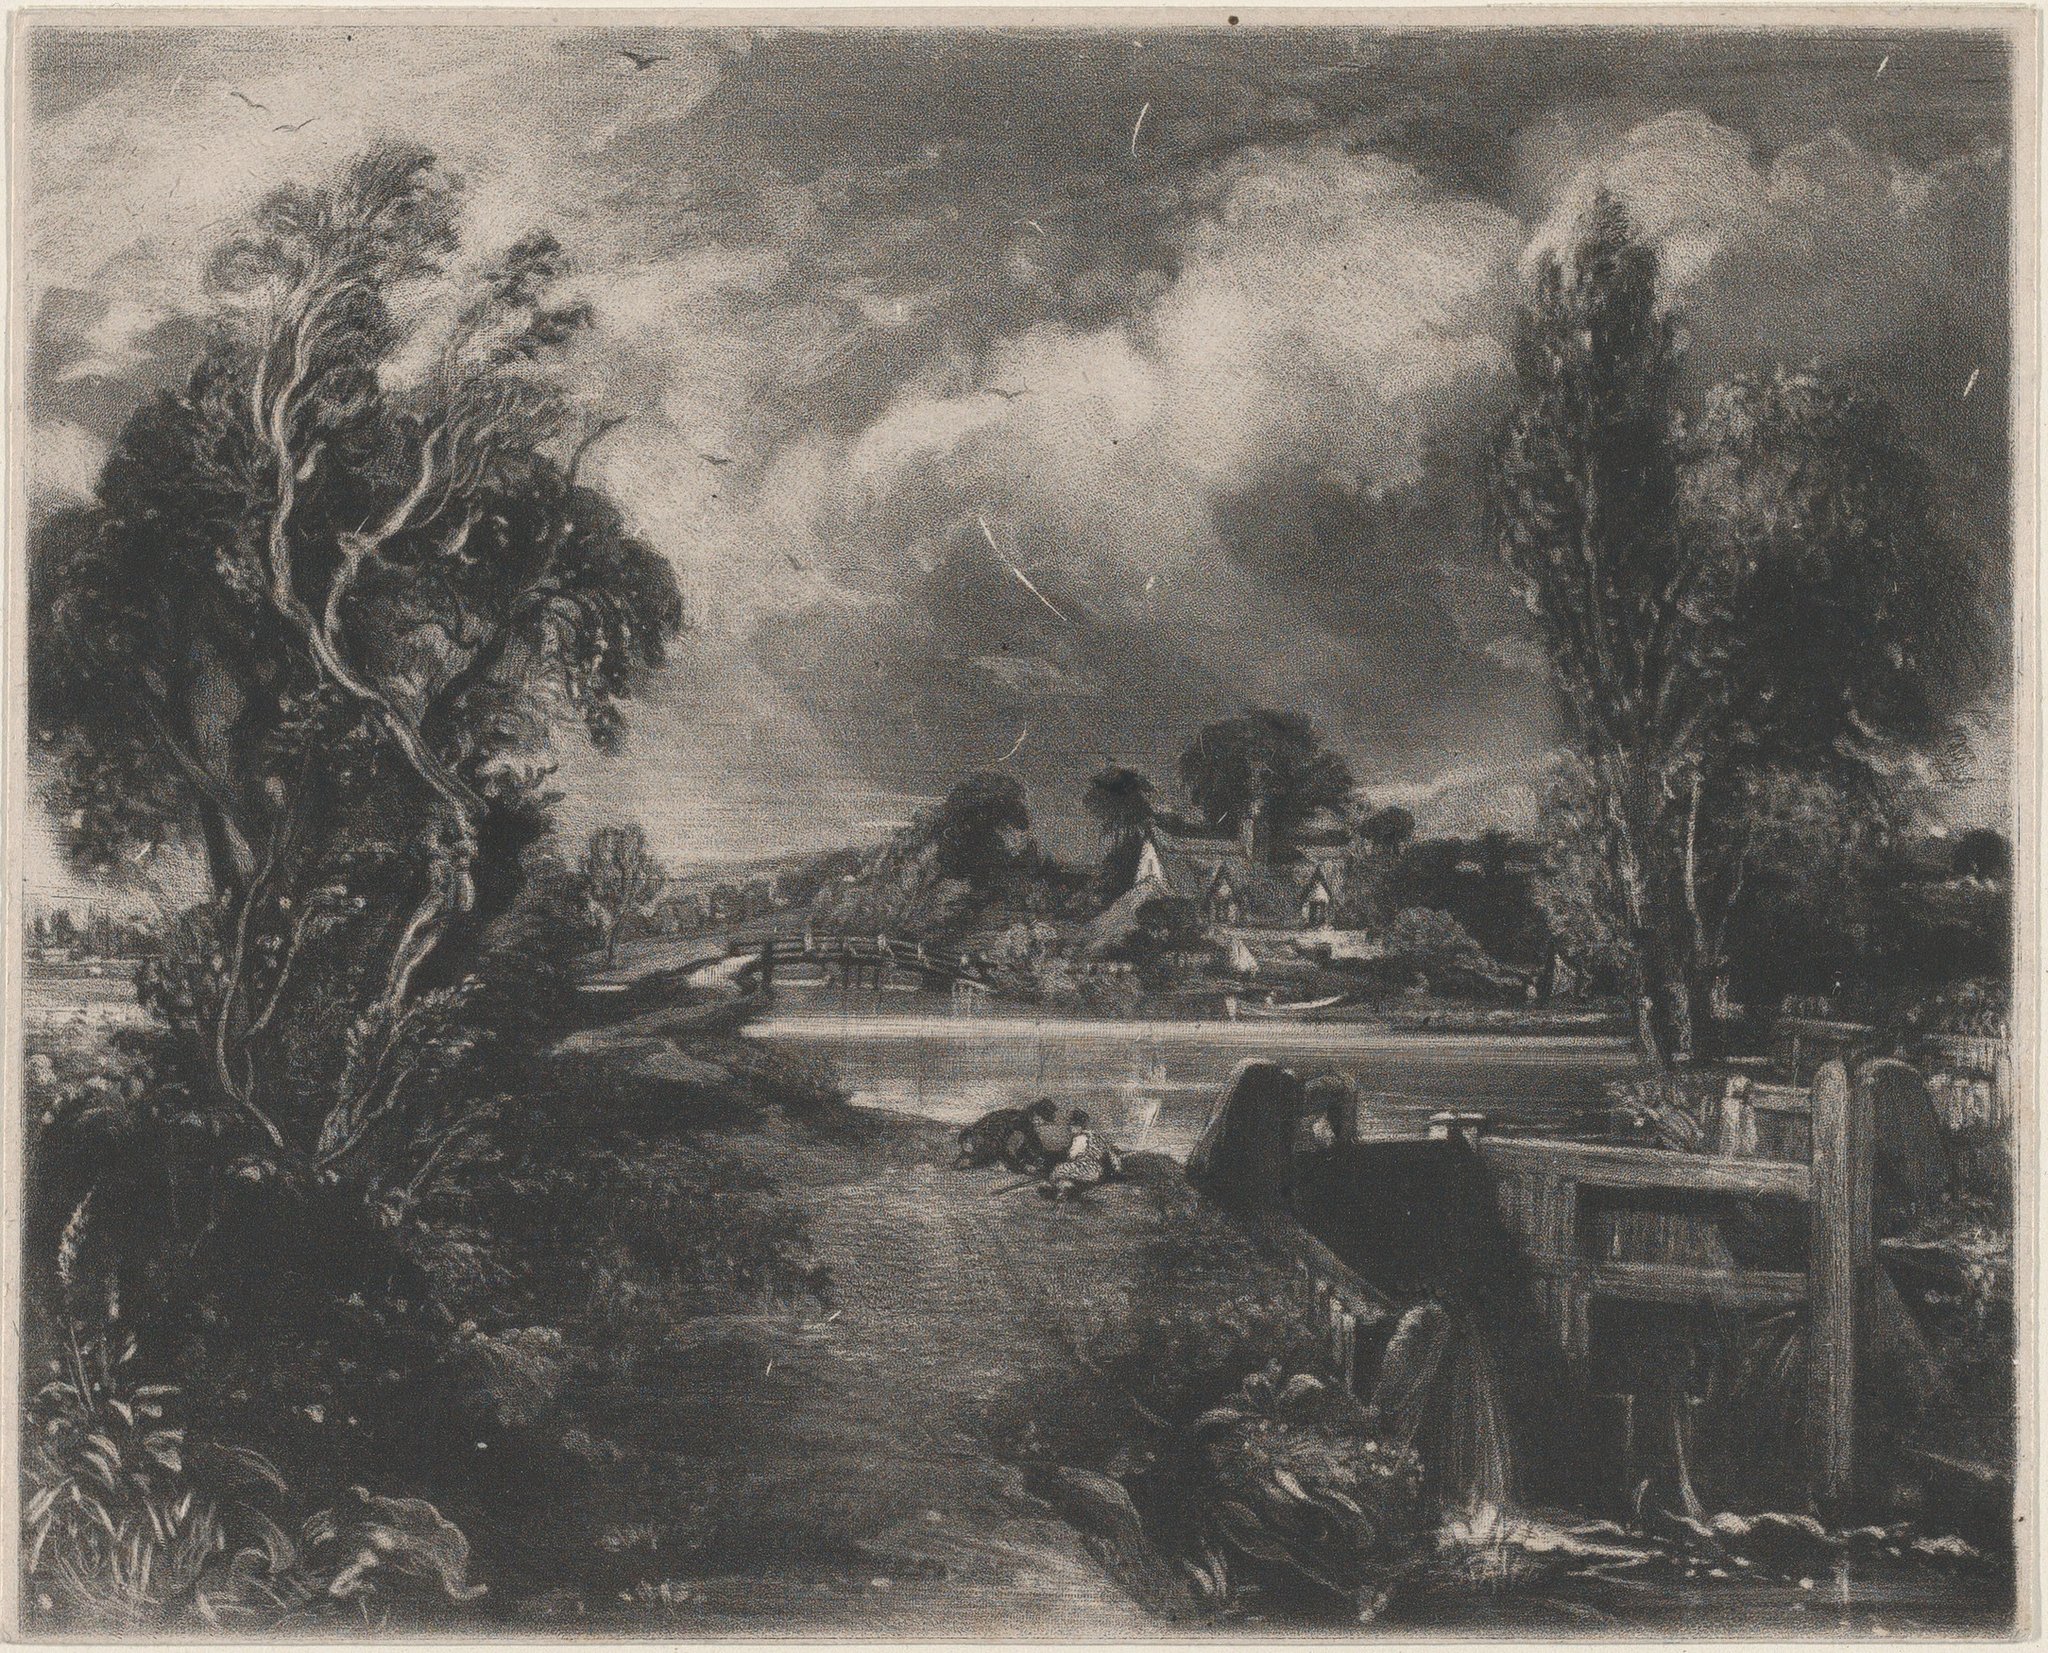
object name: print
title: A Lock on the Stour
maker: david lucas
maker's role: artist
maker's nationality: british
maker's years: 1802-1881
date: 1830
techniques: mezzotint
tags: rivers,landscapes